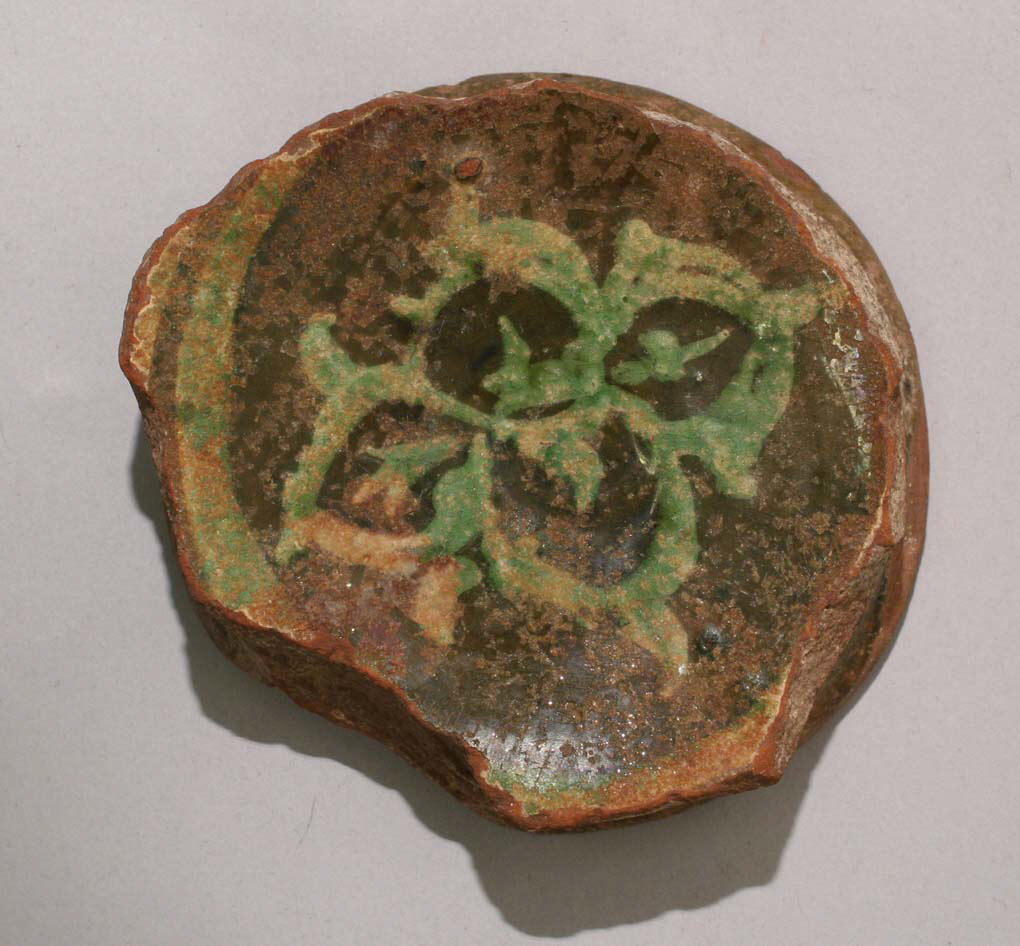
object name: ceramic fragment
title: Fragment of a Dish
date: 1301-1500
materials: earthenware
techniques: glazing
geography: egypt